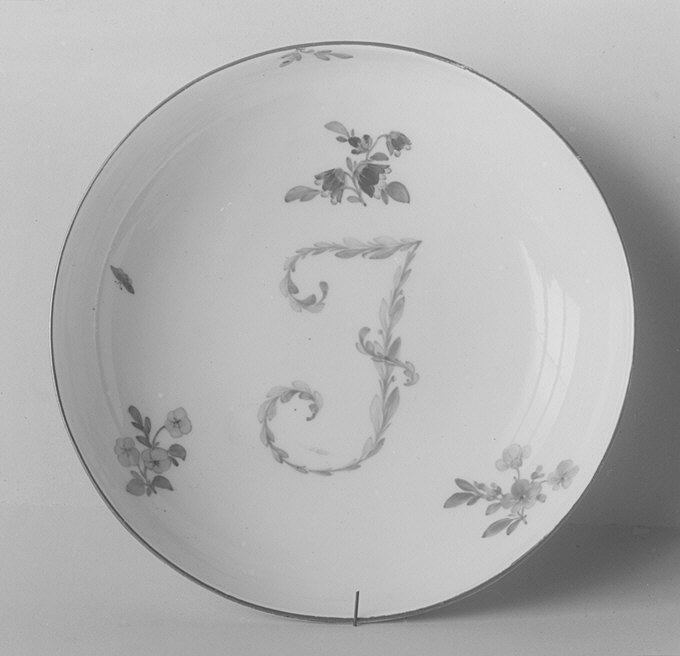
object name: saucer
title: Saucer (part of a set)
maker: royal porcelain manufactory, berlin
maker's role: manufactory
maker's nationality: german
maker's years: 1763-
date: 1765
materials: hard paste porcelain